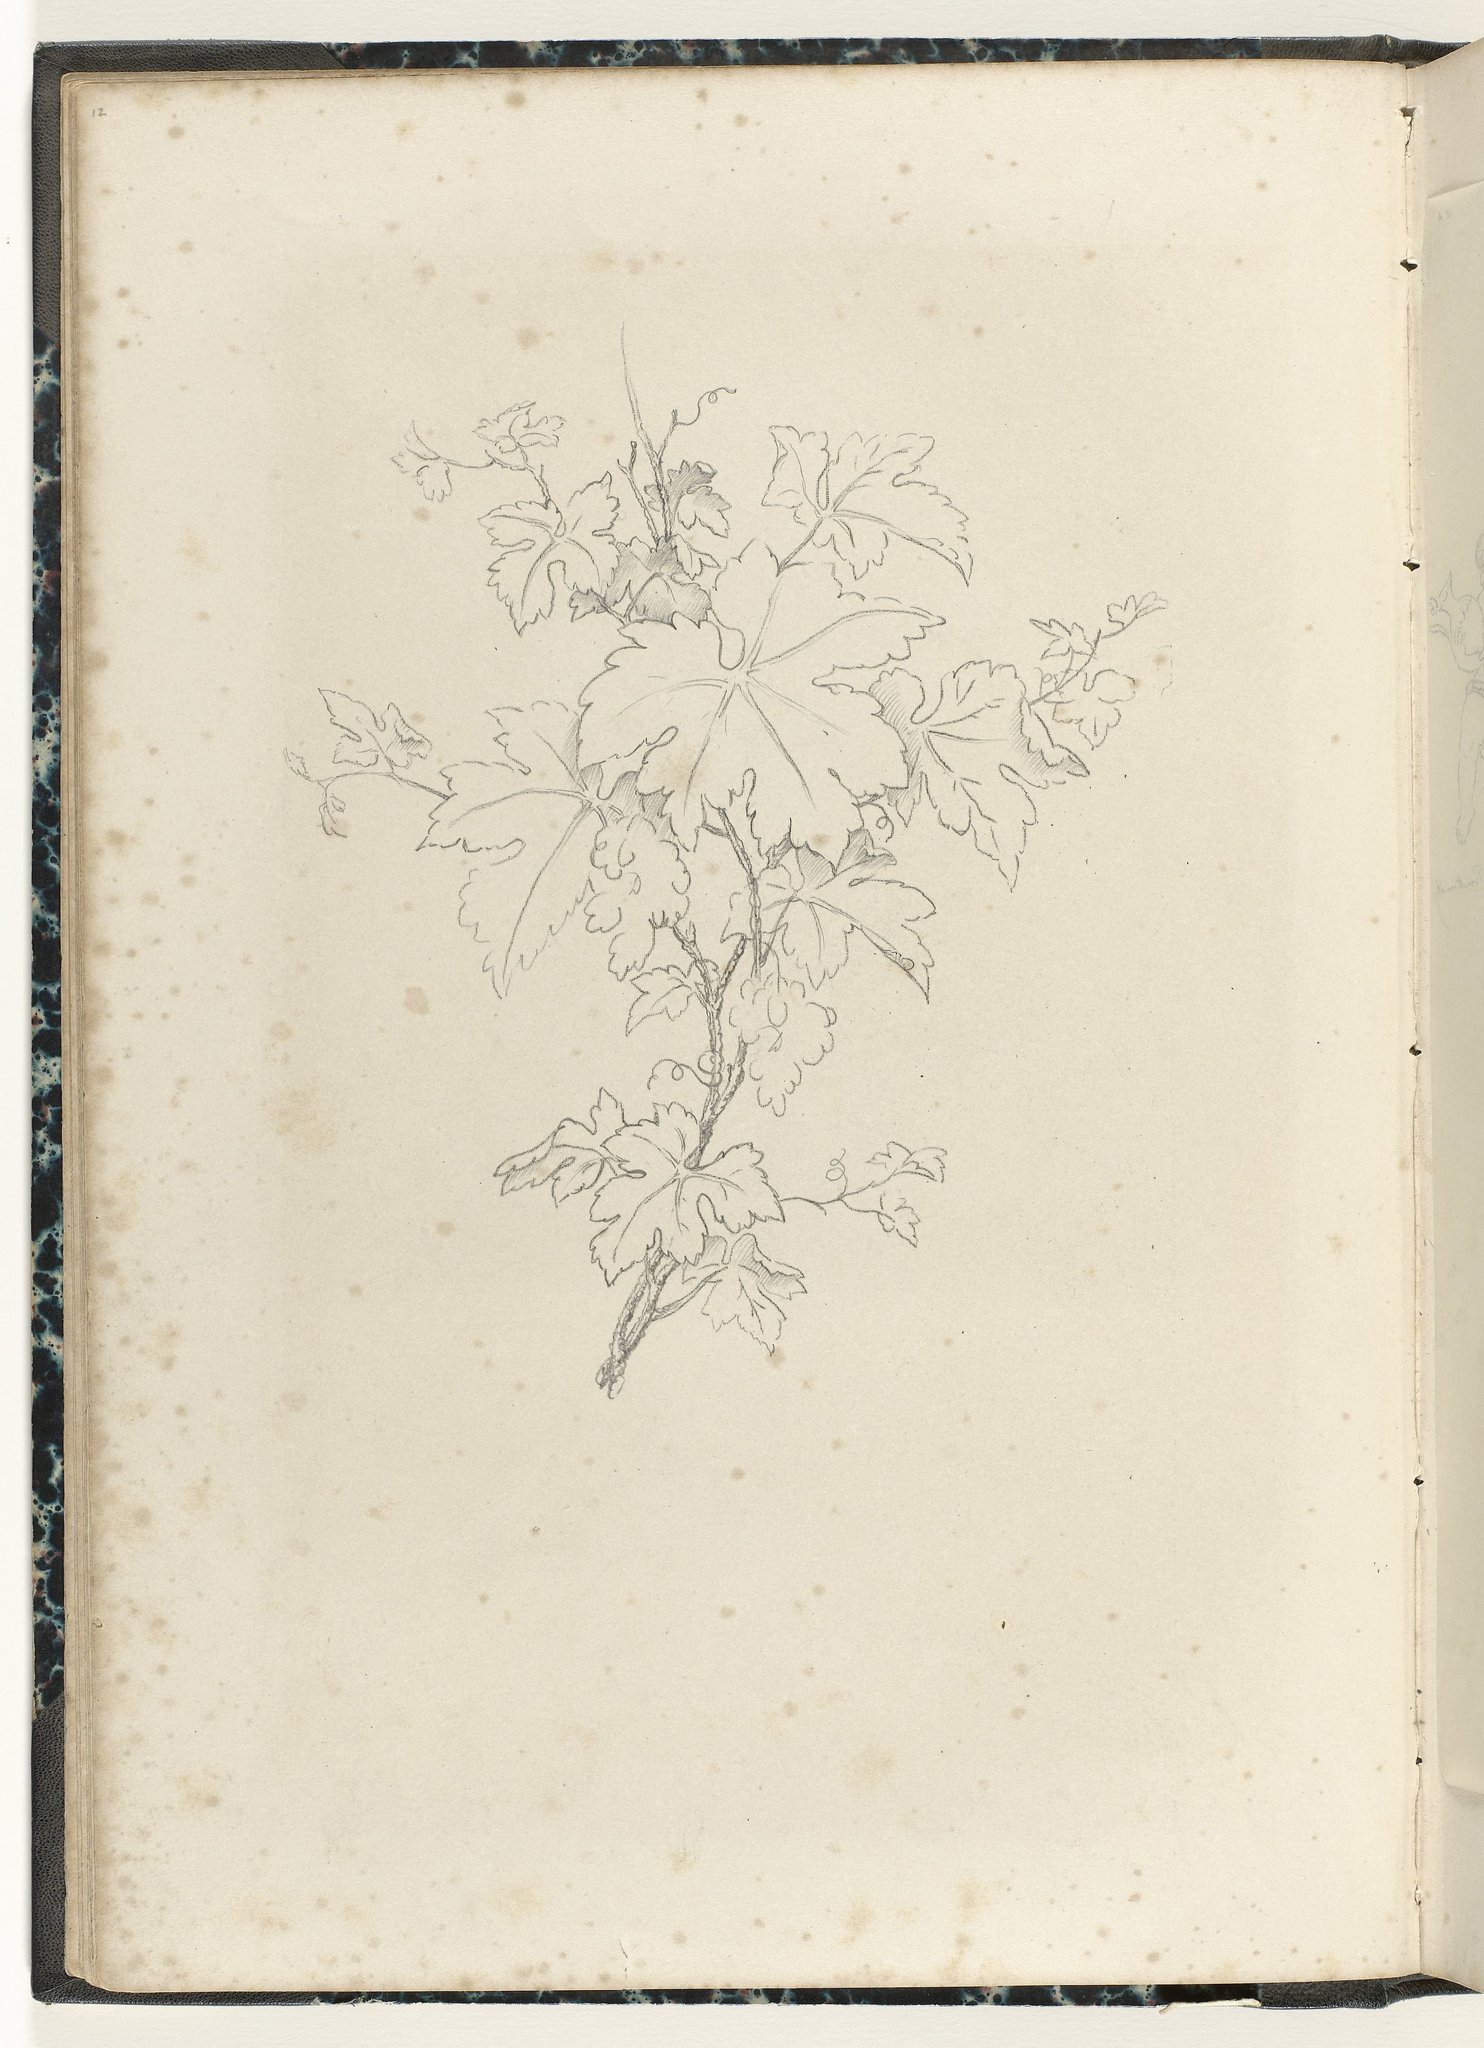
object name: drawing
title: Wijnrank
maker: Anonymous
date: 1866-1900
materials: paper, pencil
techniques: drawing